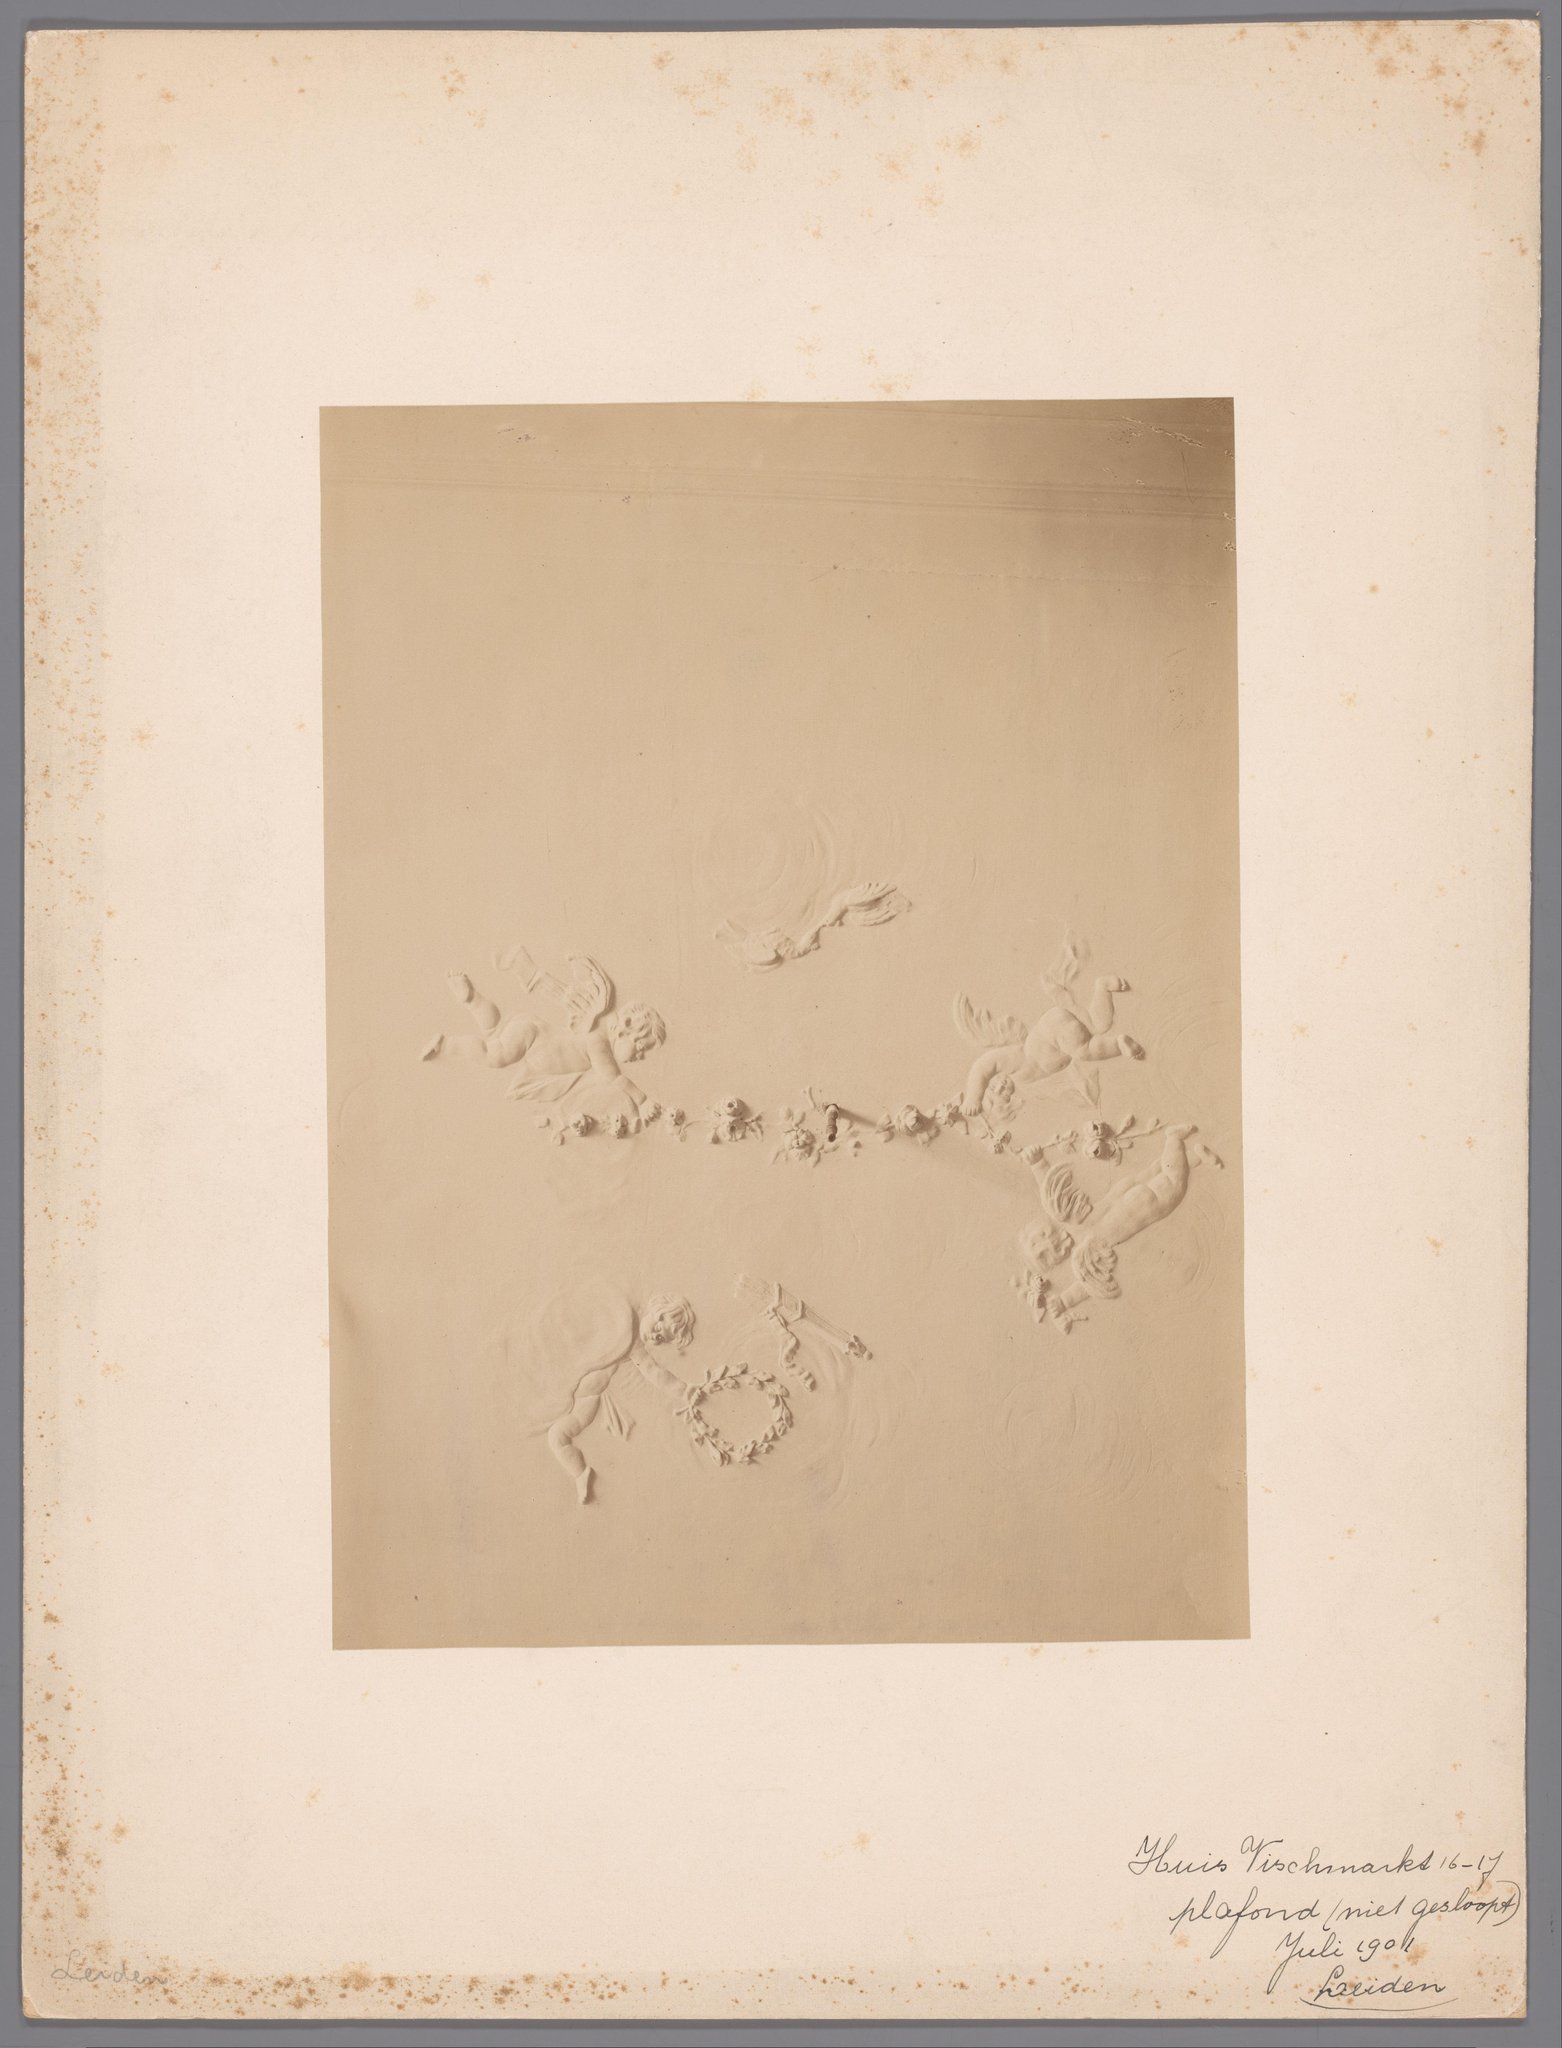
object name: photograph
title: Plafond van Vismarkt 16-17 te Leiden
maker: anoniem (monumentenzorg)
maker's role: fotograaf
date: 1901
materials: cardboard, photographic support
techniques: albumen print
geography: leiden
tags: (decorated) ceiling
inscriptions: annotation: ‘Huis Vischmarkt 16-17/ plafond (niet gesloopt)/ Juli 1901/ Leiden’, collector's mark: ‘R:MUS.’ Lugt 2228, annotation: ‘Leiden/ Huis 16-17 vischmarkt (Z.H.)/ plafond (niet gesloopt)/ Juli 1901’